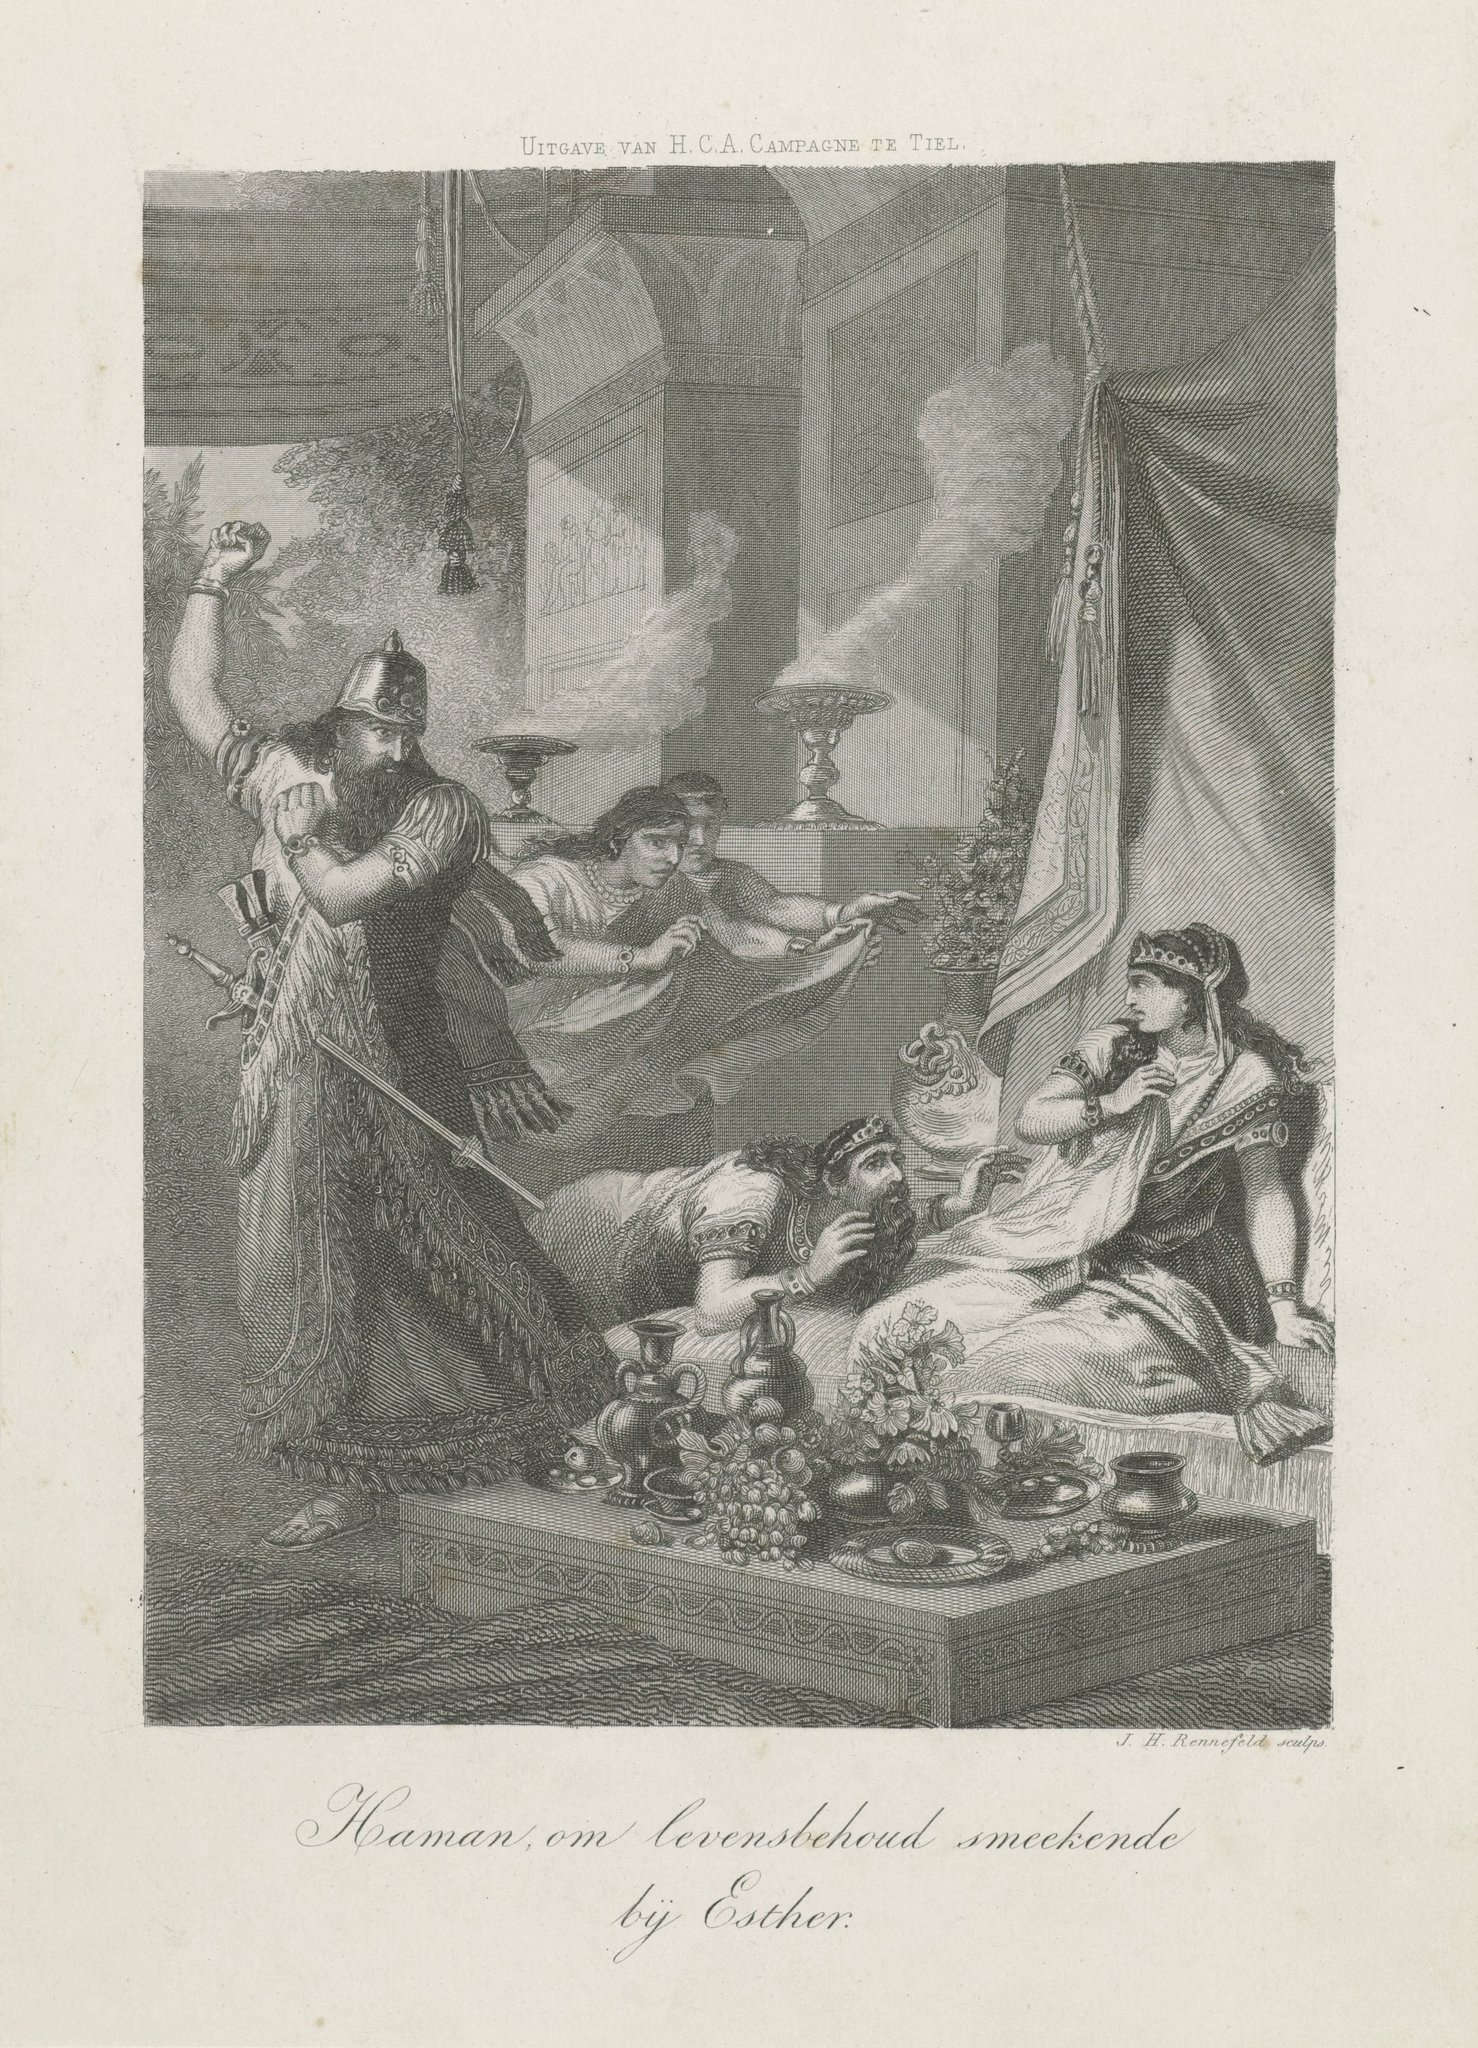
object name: print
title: Haman, om levesbehoud smeekende bij Esther.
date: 1845-1877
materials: paper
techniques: roulette, engraving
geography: amsterdam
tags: haman begs esther for his life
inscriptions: collector's mark: Lugt 2228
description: Haman knielt voor koningin Ester en smeekt haar om zijn leven. De Perzische koning Ahasveros maakt een afwijzend gebaar.